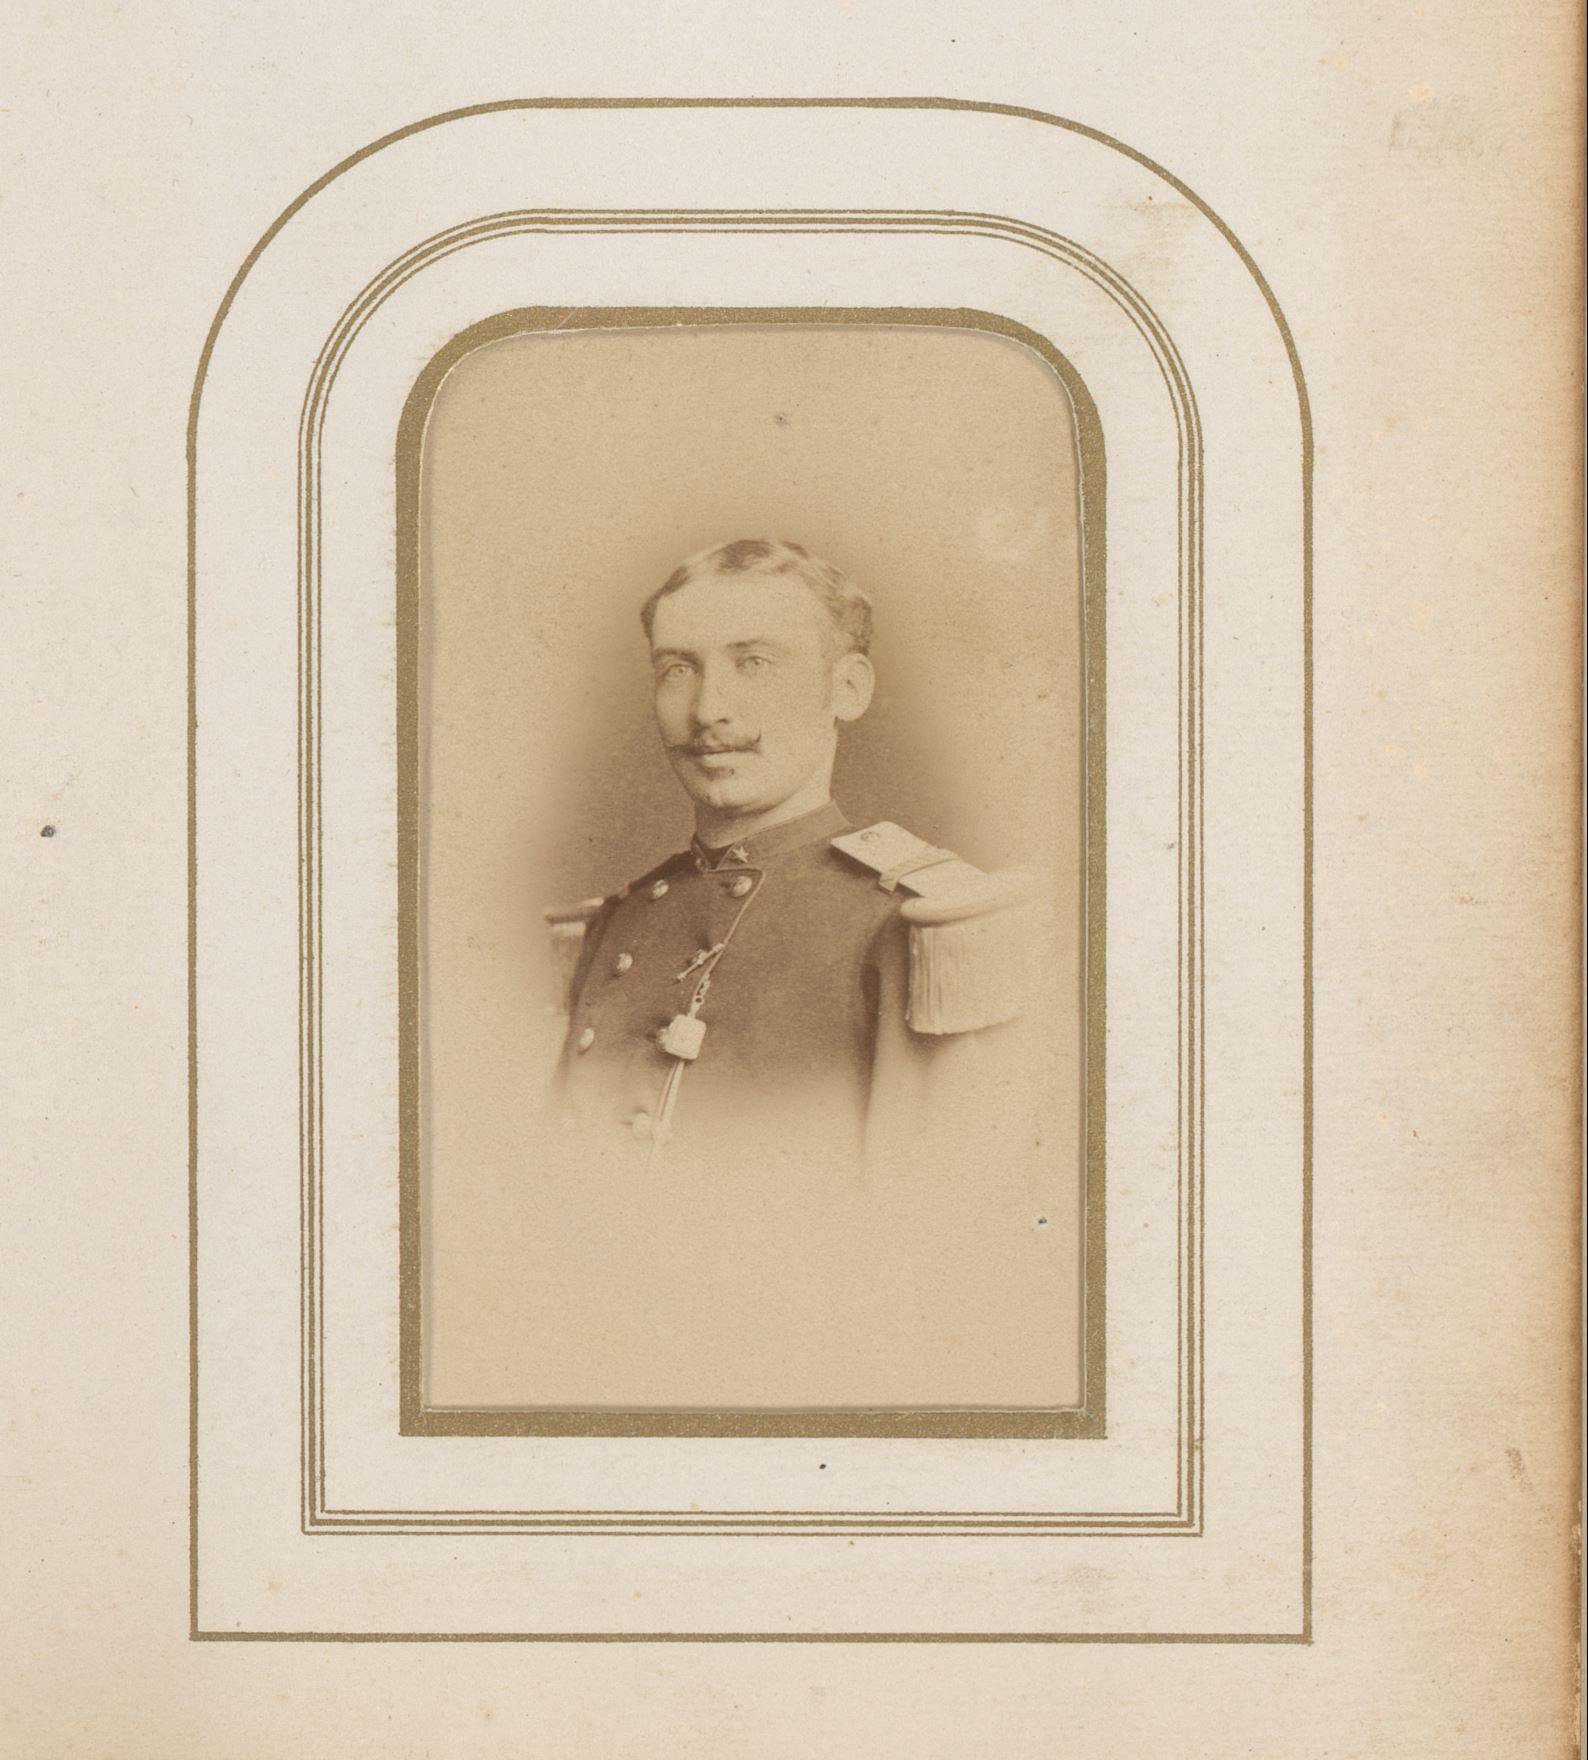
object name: album leaf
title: Portret van een man met snor in uniform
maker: raimond josz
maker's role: fotograaf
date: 1871-1877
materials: cardboard, celluloid, photographic support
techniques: albumen print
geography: bergen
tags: historical persons, (military) uniforms, beard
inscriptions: inscription: ‘R. Josz/ 26, Rue de Nimy 26/ Mons’